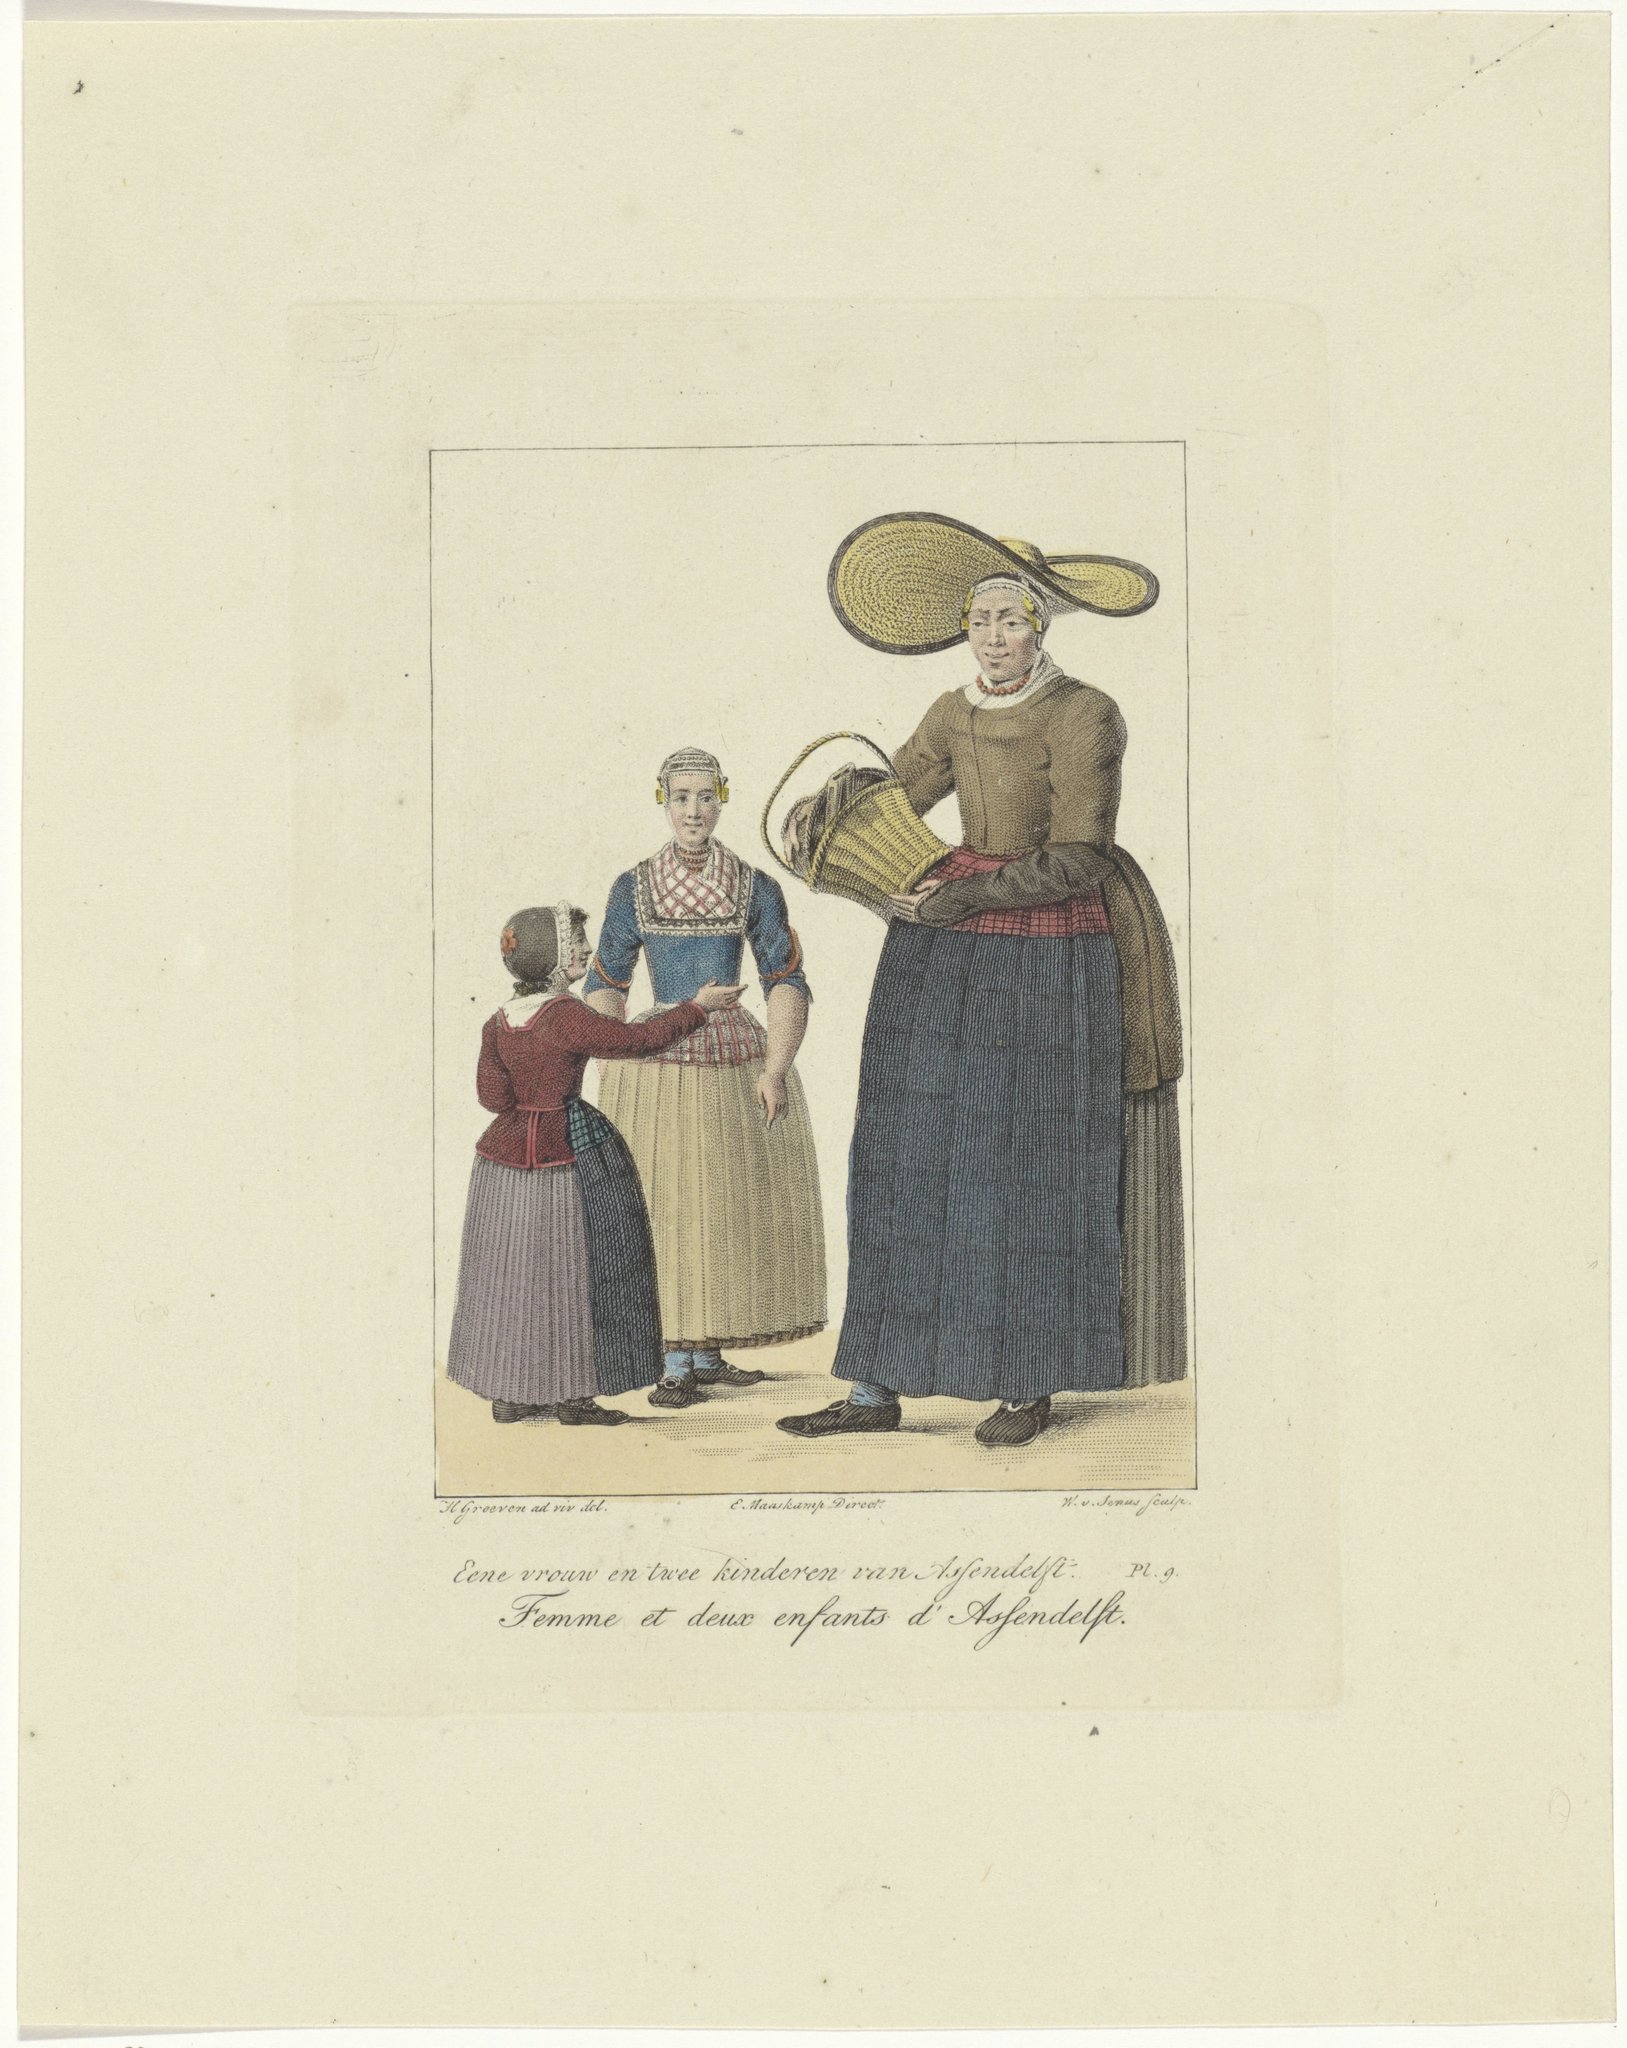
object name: print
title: Eene vrouw en twee kinderen van Assendelft/ Femme et deux enfants d'Assendelft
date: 1824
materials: paper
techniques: engraving, hand coloring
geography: amsterdam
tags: folk costume, regional costume, mother and daughter(s) (family group) (with number of daughters), assendelft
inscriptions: collector's mark: Lugt 2228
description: Prent gebruikt in: Maaskamp, Evert. Tableau des principales vues des palais et édifices : représentations et des coutumes et usages, dans les provinces septentrionales du Royaume des Pays-Bas. Amsterdam, 1824.